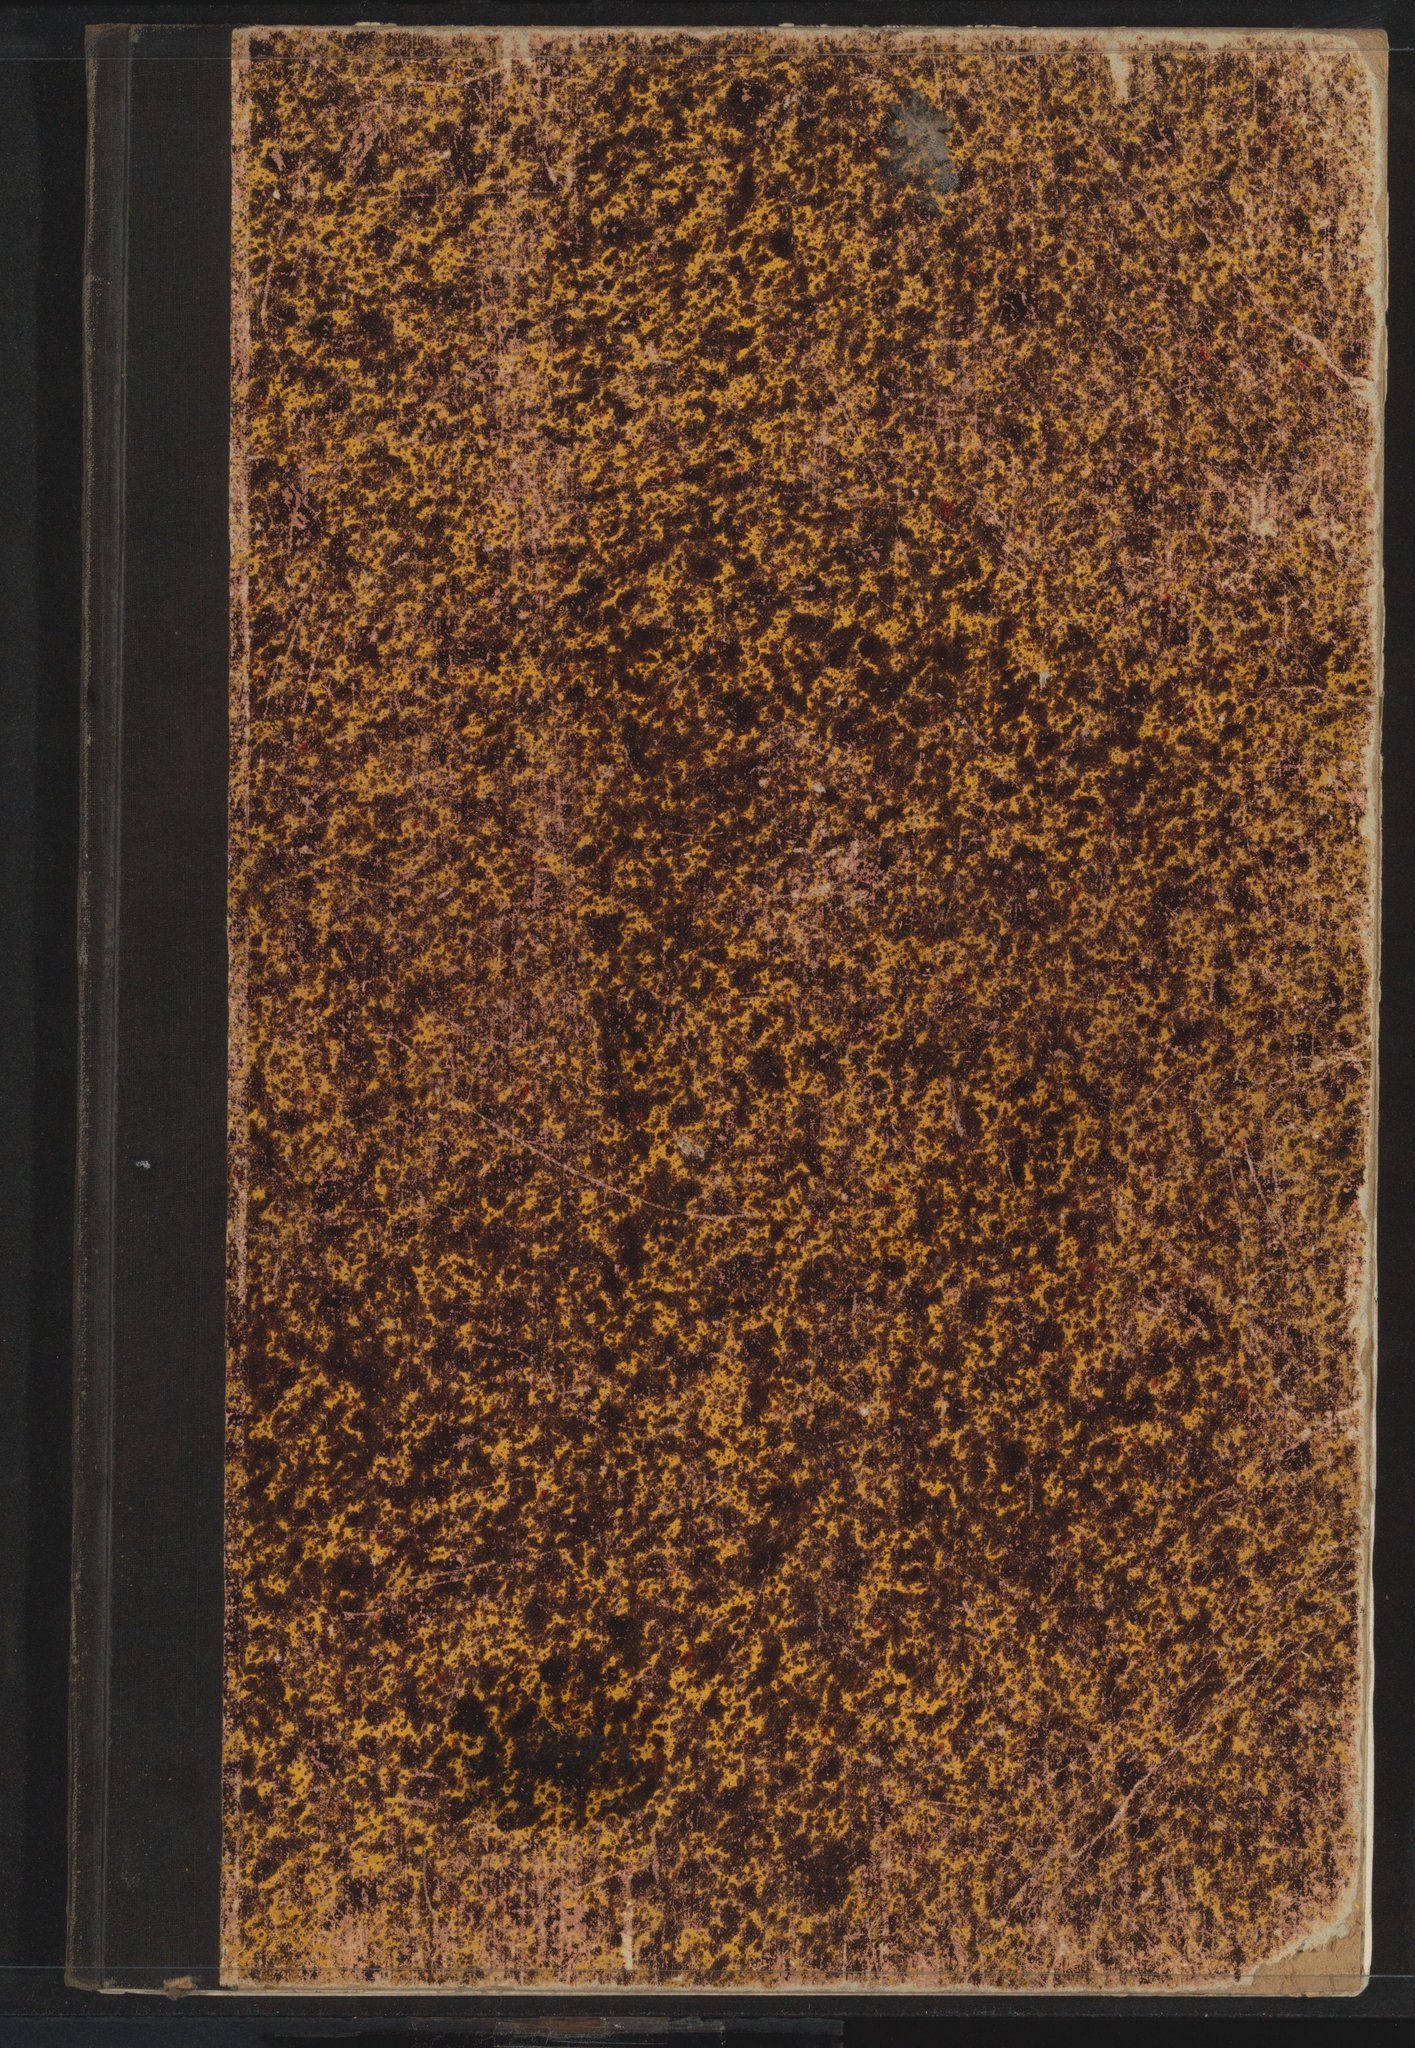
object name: sketchbook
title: Schetsboek LXVIII met 11 bladen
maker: isaac israels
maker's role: draughtsman, painter, print maker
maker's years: 1865-1934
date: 1875-1934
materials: cardboard, chalk, linen, paper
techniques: splatter marble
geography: the hague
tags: vaudeville, variety-show, the (nude) human figure; 'corpo humano' (ripa) - aa - female human figure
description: Schetsboek nr. LXVIII bestaande uit 11 bladen met variétéscènes en vrouwelijke naakten.